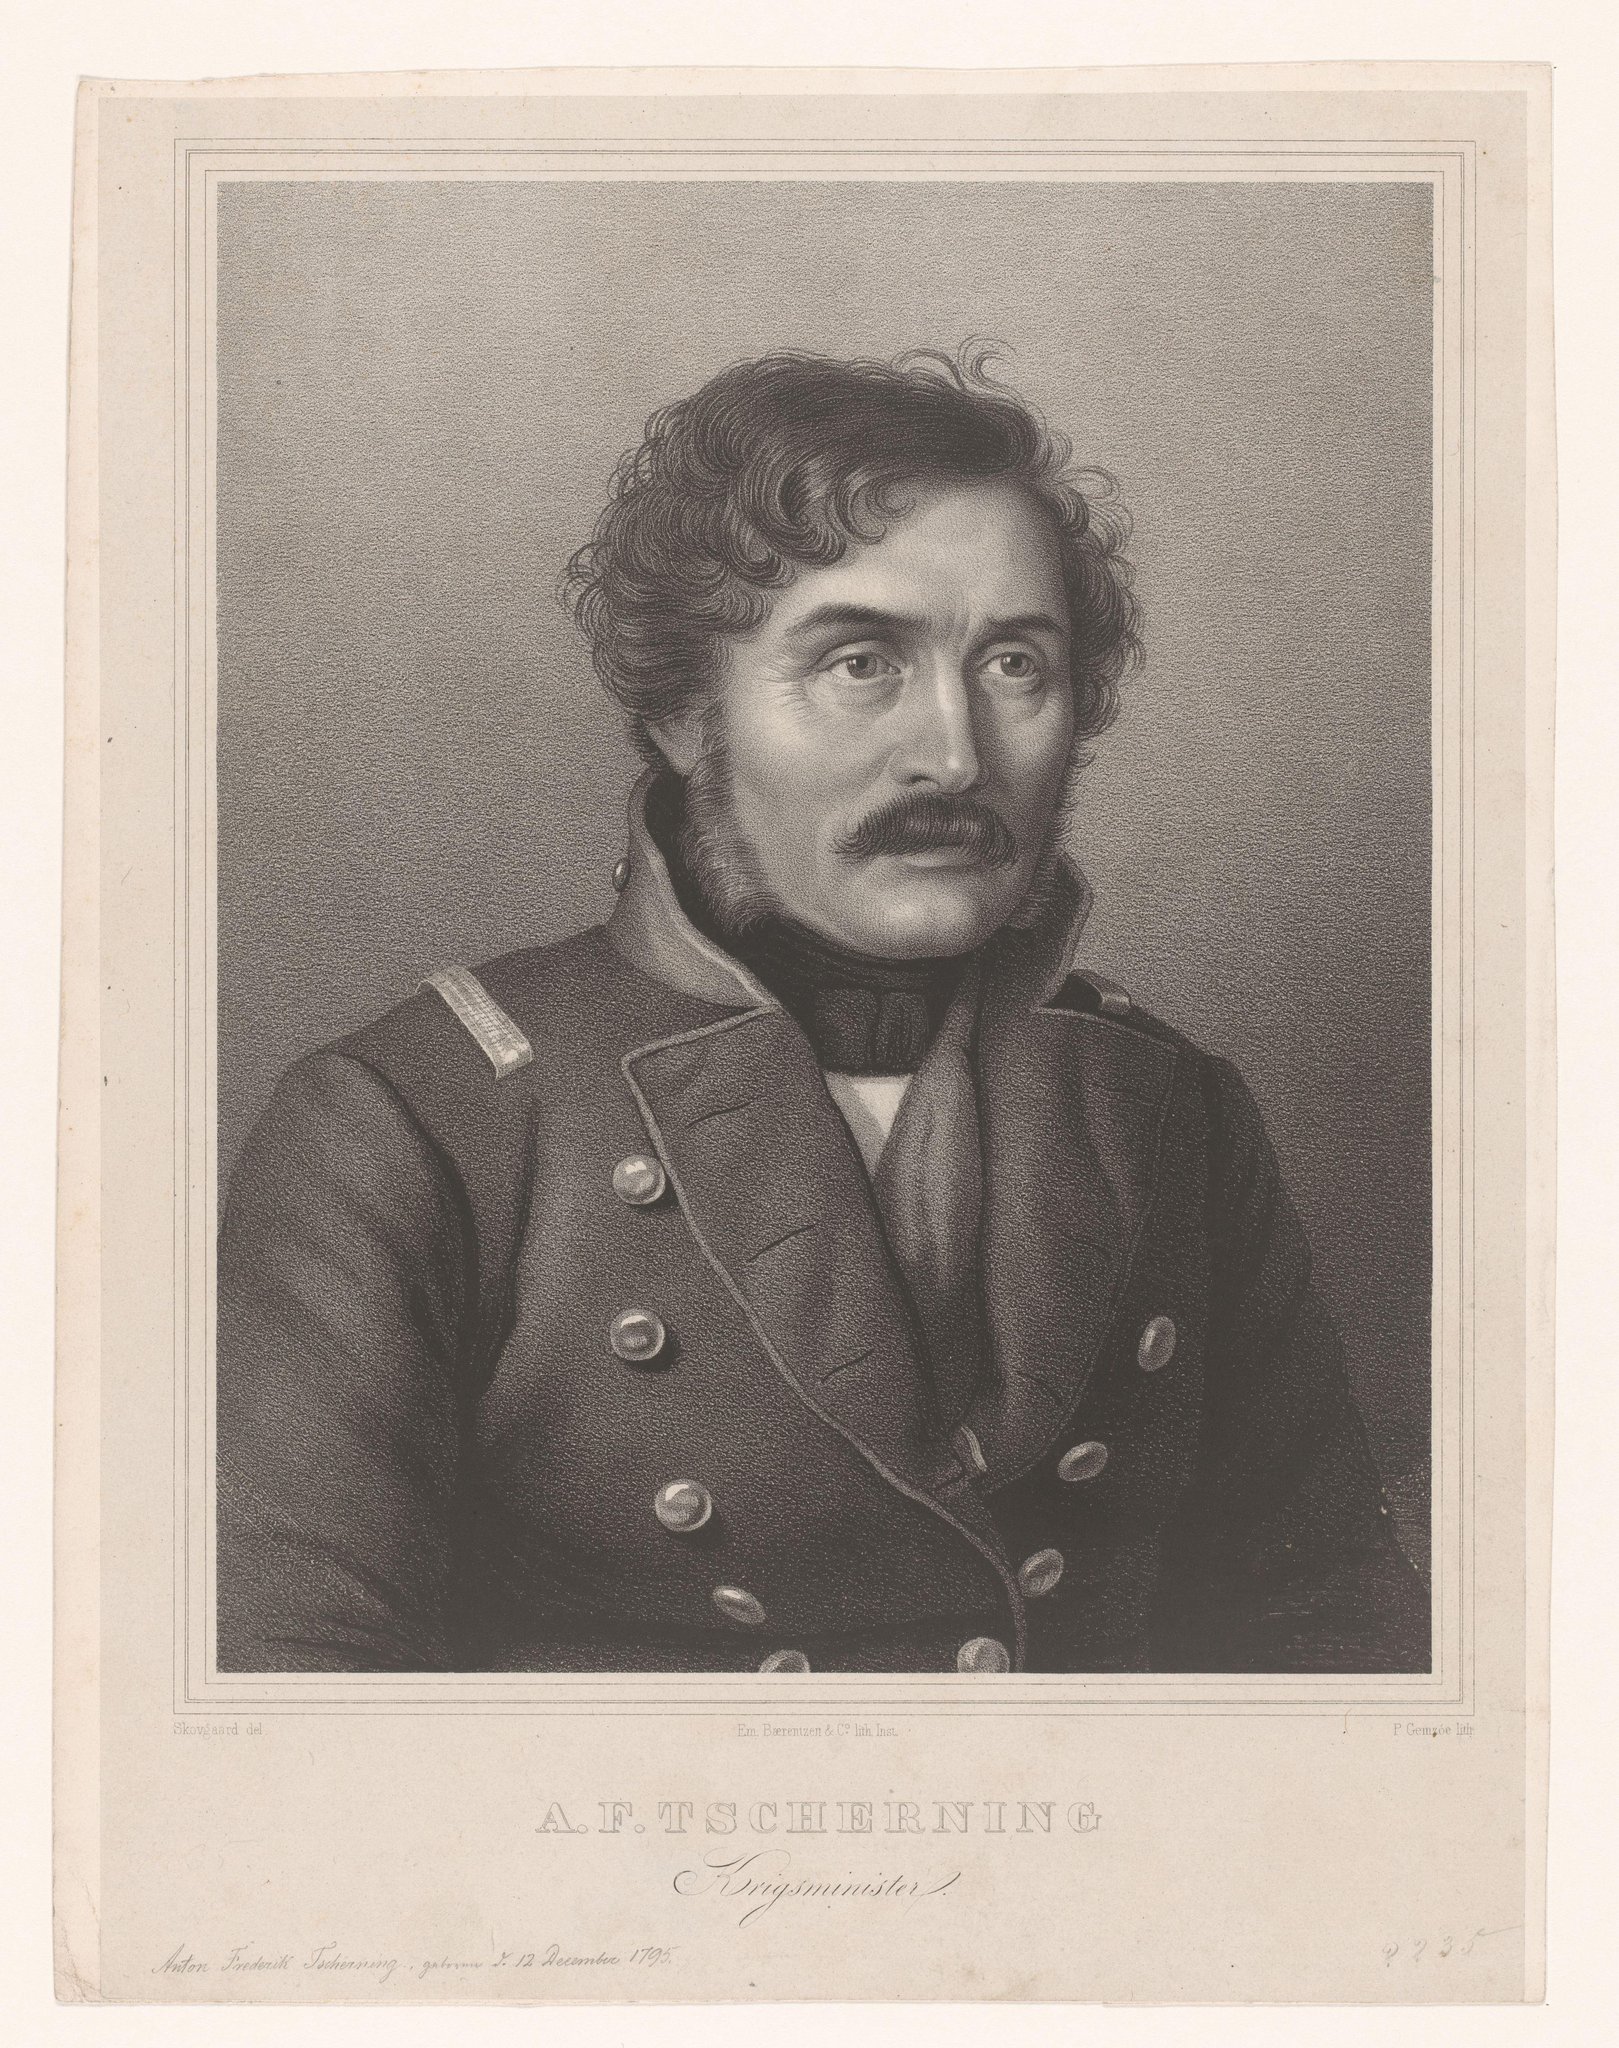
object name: print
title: Portret van Anton Frederik Tscherning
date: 1837-1879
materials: paper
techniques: lithograph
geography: copenhagen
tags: historical persons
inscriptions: signature: ‘P. Gemzóe lith.’, signature: ‘Skovgaard del’, inscription: ‘Anton Frederik Tscherning, geboren te 12 December 1795.’, collector's mark: Lugt 2228, signature: ‘Em. Baerentzen & Co lith. Inst.’, inscription: ‘A.F. Tscherning / Krigsminister’